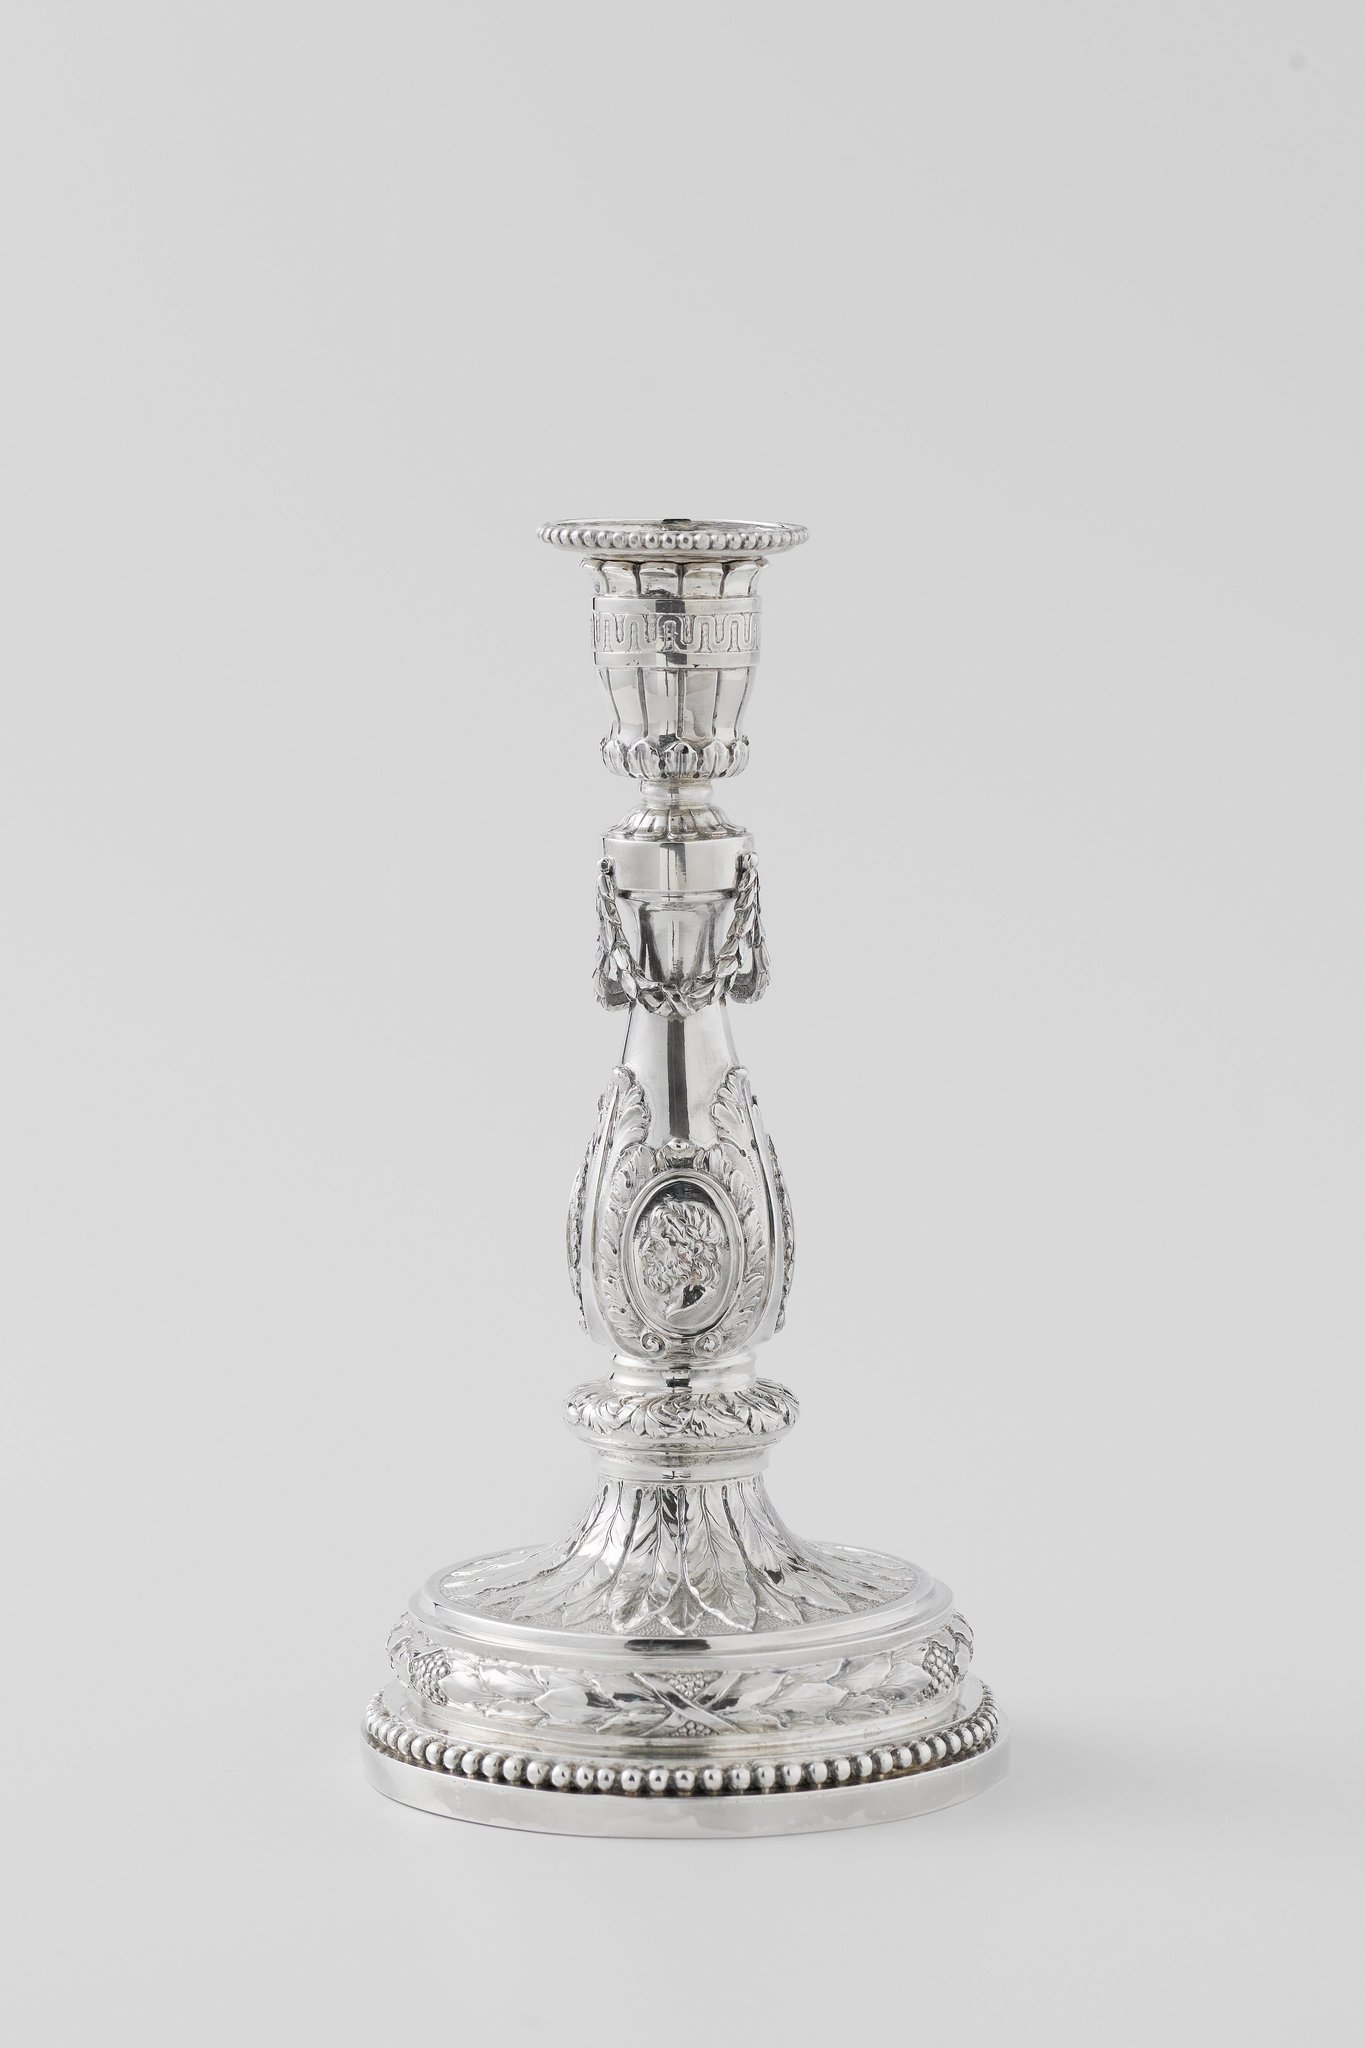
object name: candlestick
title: Pair of candlesticks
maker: johannes schiotling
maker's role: silversmith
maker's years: 1730-1799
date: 1785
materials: silver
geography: amsterdam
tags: ornaments ~ art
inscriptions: date letter: ‘A’, alloy mark, duty mark, town mark, maker's mark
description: These candlesticks with acanthus leaves, medallions and festoons were inspired by a design by Paris artist Jean François Forty that was published around 1780. This type of short candlestick was probably intended for a dressing or gaming table.